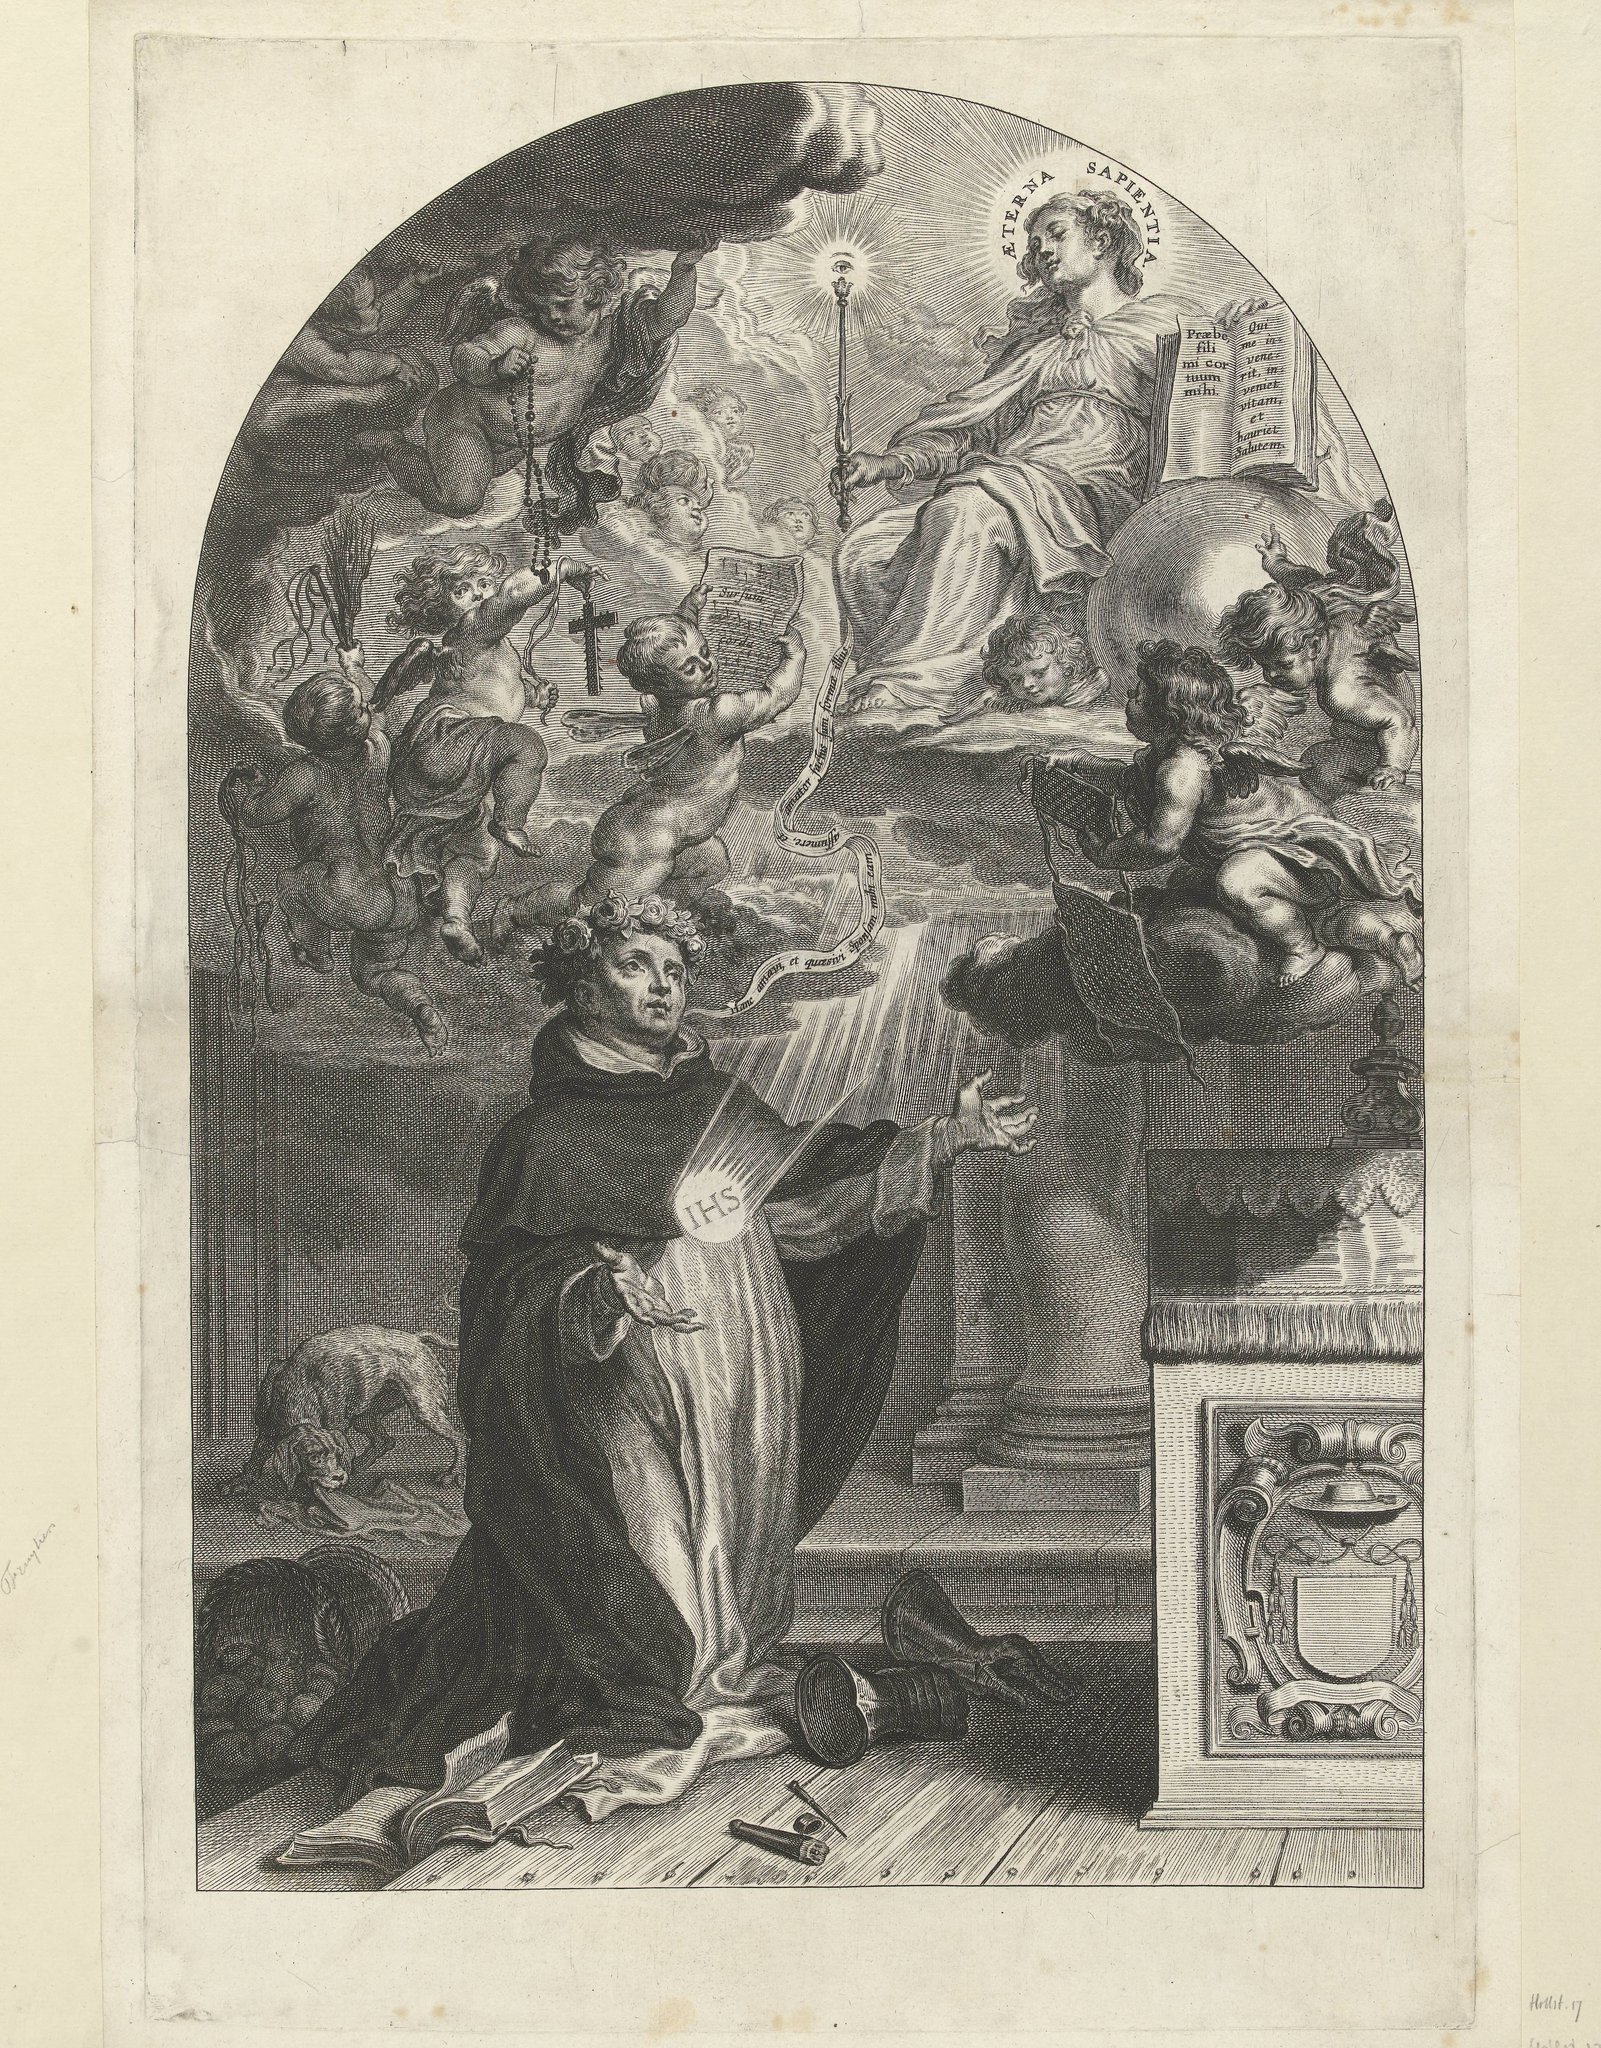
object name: print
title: Geknielde dominicaan voor een altaar, waarschijnlijk Hendrik Seuse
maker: philip fruytiers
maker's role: print maker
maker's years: 1610-1666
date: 1620-1666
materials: paper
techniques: engraving, etching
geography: antwerp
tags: cupids: 'amores', 'amoretti', 'putti', 'sapientia', wisdom; 'sapienza divina' (ripa) ~ one of the seven gifts of the holy ghost, monastic orders, monastic life: dominicans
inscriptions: collector's mark: Lugt 12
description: De dominicaan zit geknield voor een altaar waar twee engelen boven vliegen. Hij is gehuld in een habijt waarop ter hoogte van zijn hart de letters IHS - Iesus Hominum Salvator, of te wel: Jezus, redder van de mensheid - stralen. Zijn hoofd is getooid met een bloemenkrans. In de lucht boven de Jezuïet vliegen engelen met diverse attributen. Rechts hiervan zetelt Aeterna Sapientia, Gods eeuwige wijsheid, met in haar linkerhand een opengeslagen boek en in haar rechterhand een staf waarboven het Alziend Oog straalt.